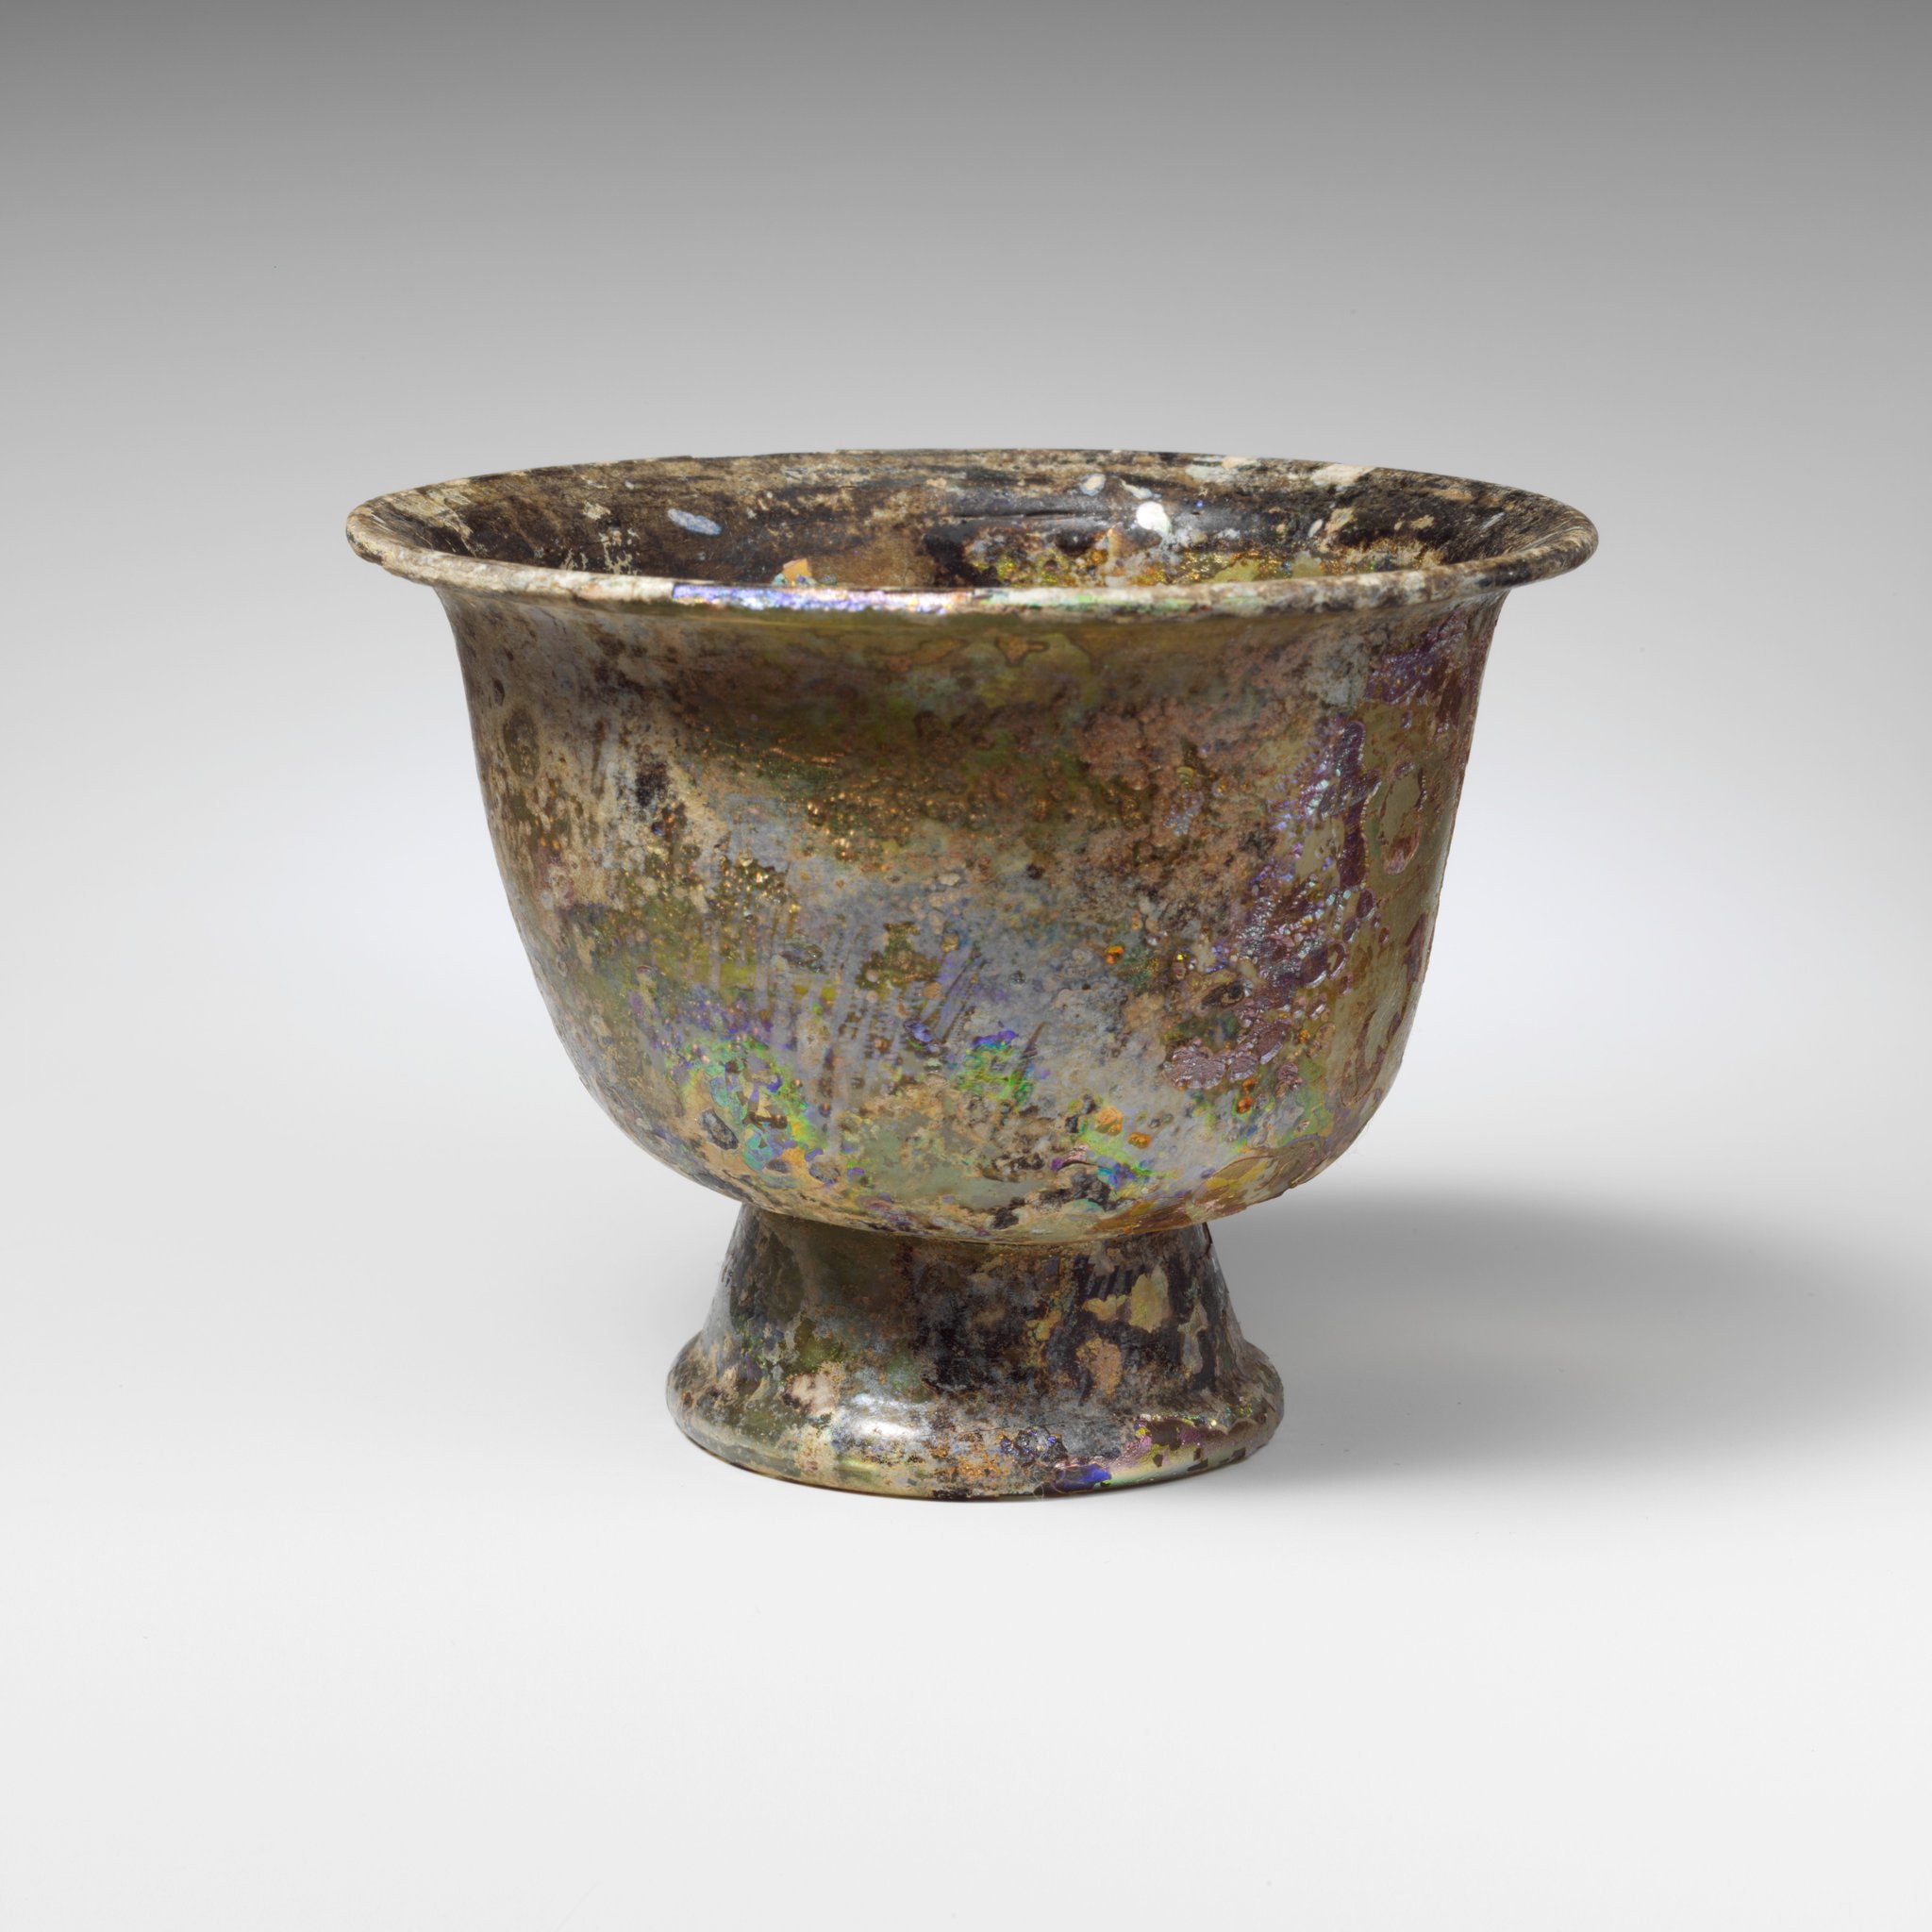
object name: bowl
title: Glass footed bowl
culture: roman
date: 201-400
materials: glass